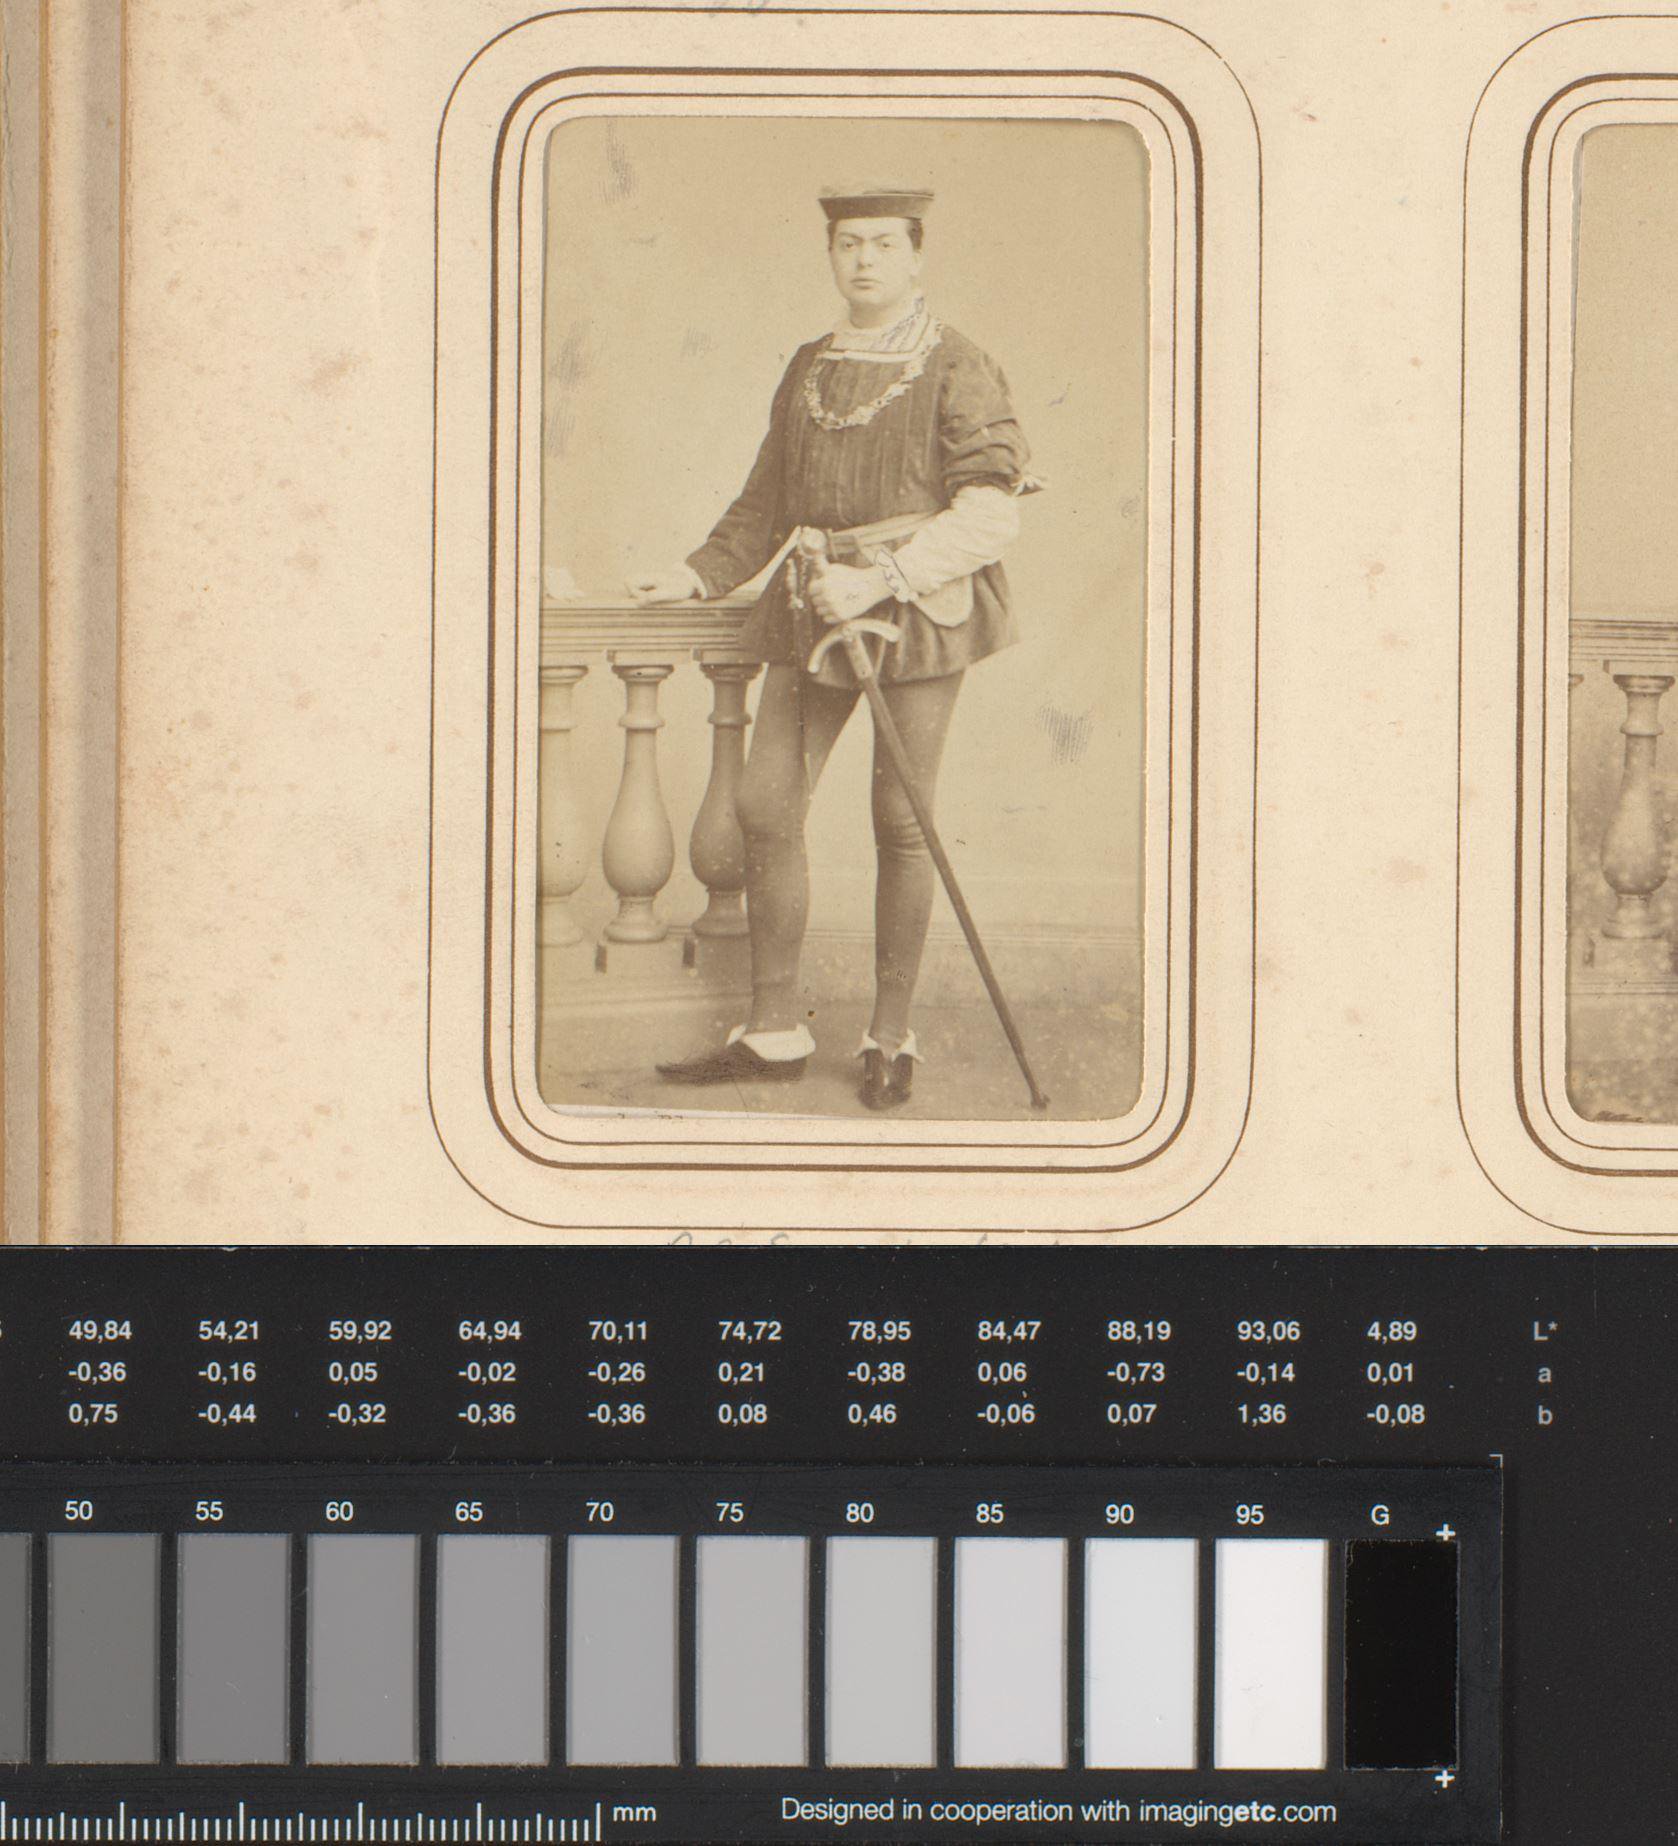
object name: album leaf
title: Portret van een jonge man in kostuum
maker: henri pronk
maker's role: fotograaf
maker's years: 1813-1893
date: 1860-1890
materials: cardboard, photographic support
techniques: albumen print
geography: utrecht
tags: stage costume, youth, adolescent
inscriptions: inscription: ‘H. Pronk, Photographe. Utrecht.’